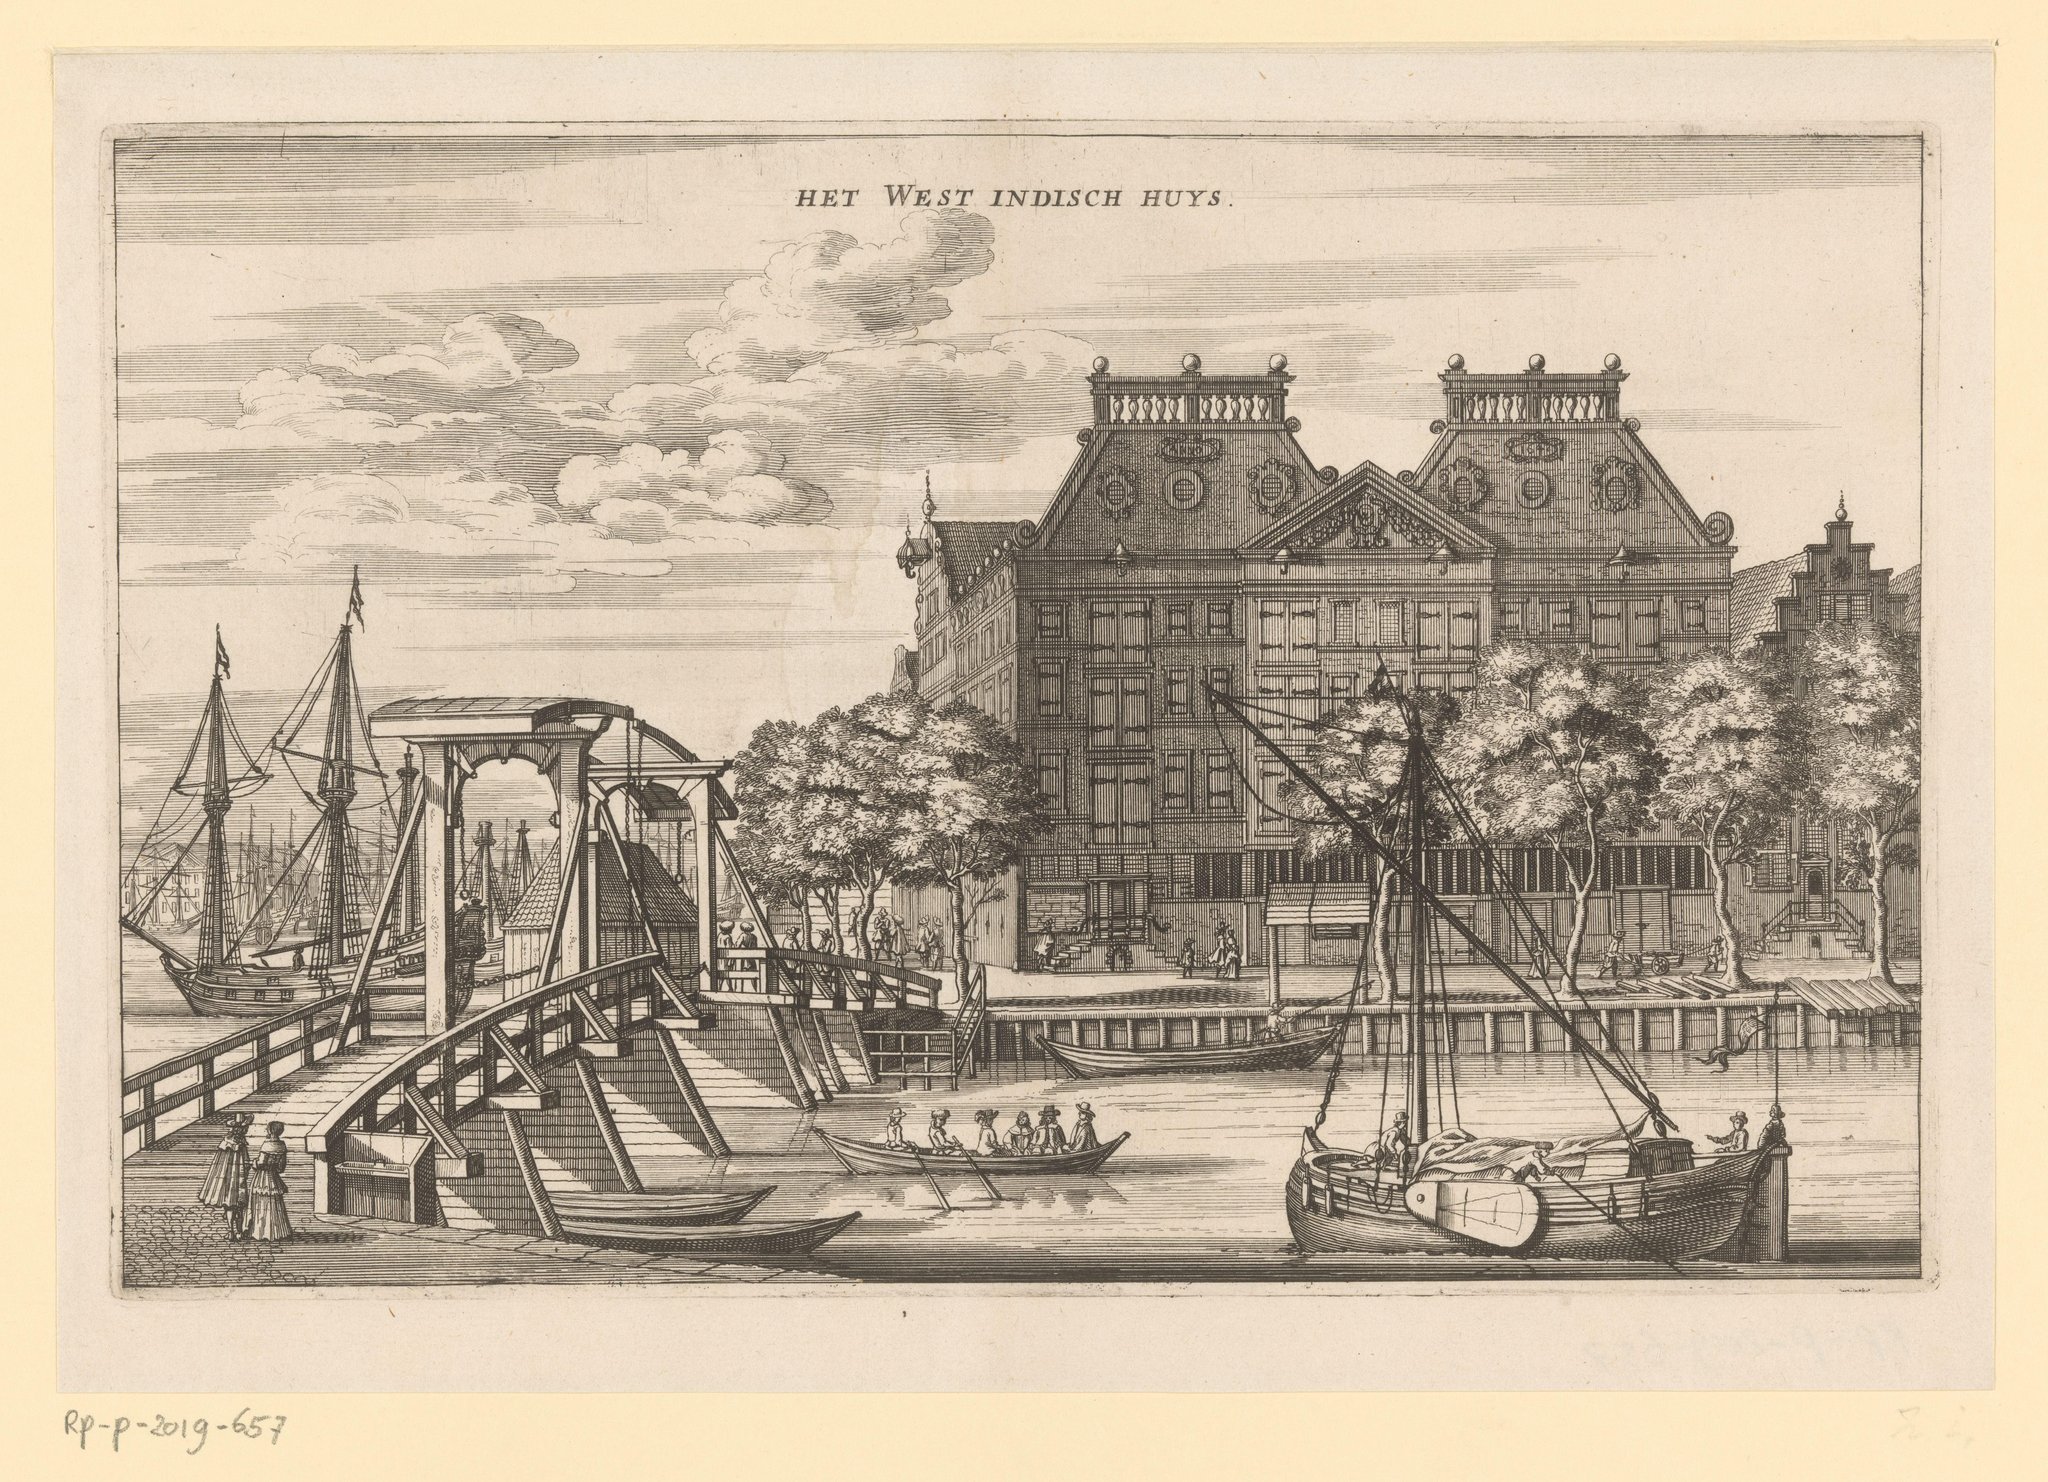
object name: book illustration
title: Het West Indisch Huys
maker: jacob van meurs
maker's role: draughtsman, print maker, publisher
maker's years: 1619-1680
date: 1663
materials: paper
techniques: engraving, etching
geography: amsterdam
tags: warehouse (~ harbour), trade-company, bridge in city across river, canal, etc. (+ city(-scape) with figures, staffage), canals, waters (in city) (+ city(-scape) with figures, staffage), street (+ city(-scape) with figures, staffage)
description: Prent uit: Dapper, Olfert. Historische beschryving der stadt Amsterdam: waer in de voornaemste geschiedenissen (na een kort verhael van gansch Hollant en d'omleggende dorpen (…). Amsterdam: Jacob van Meurs, 1663. De tweede staat van de prent heeft een toegevoegde Franse titel.